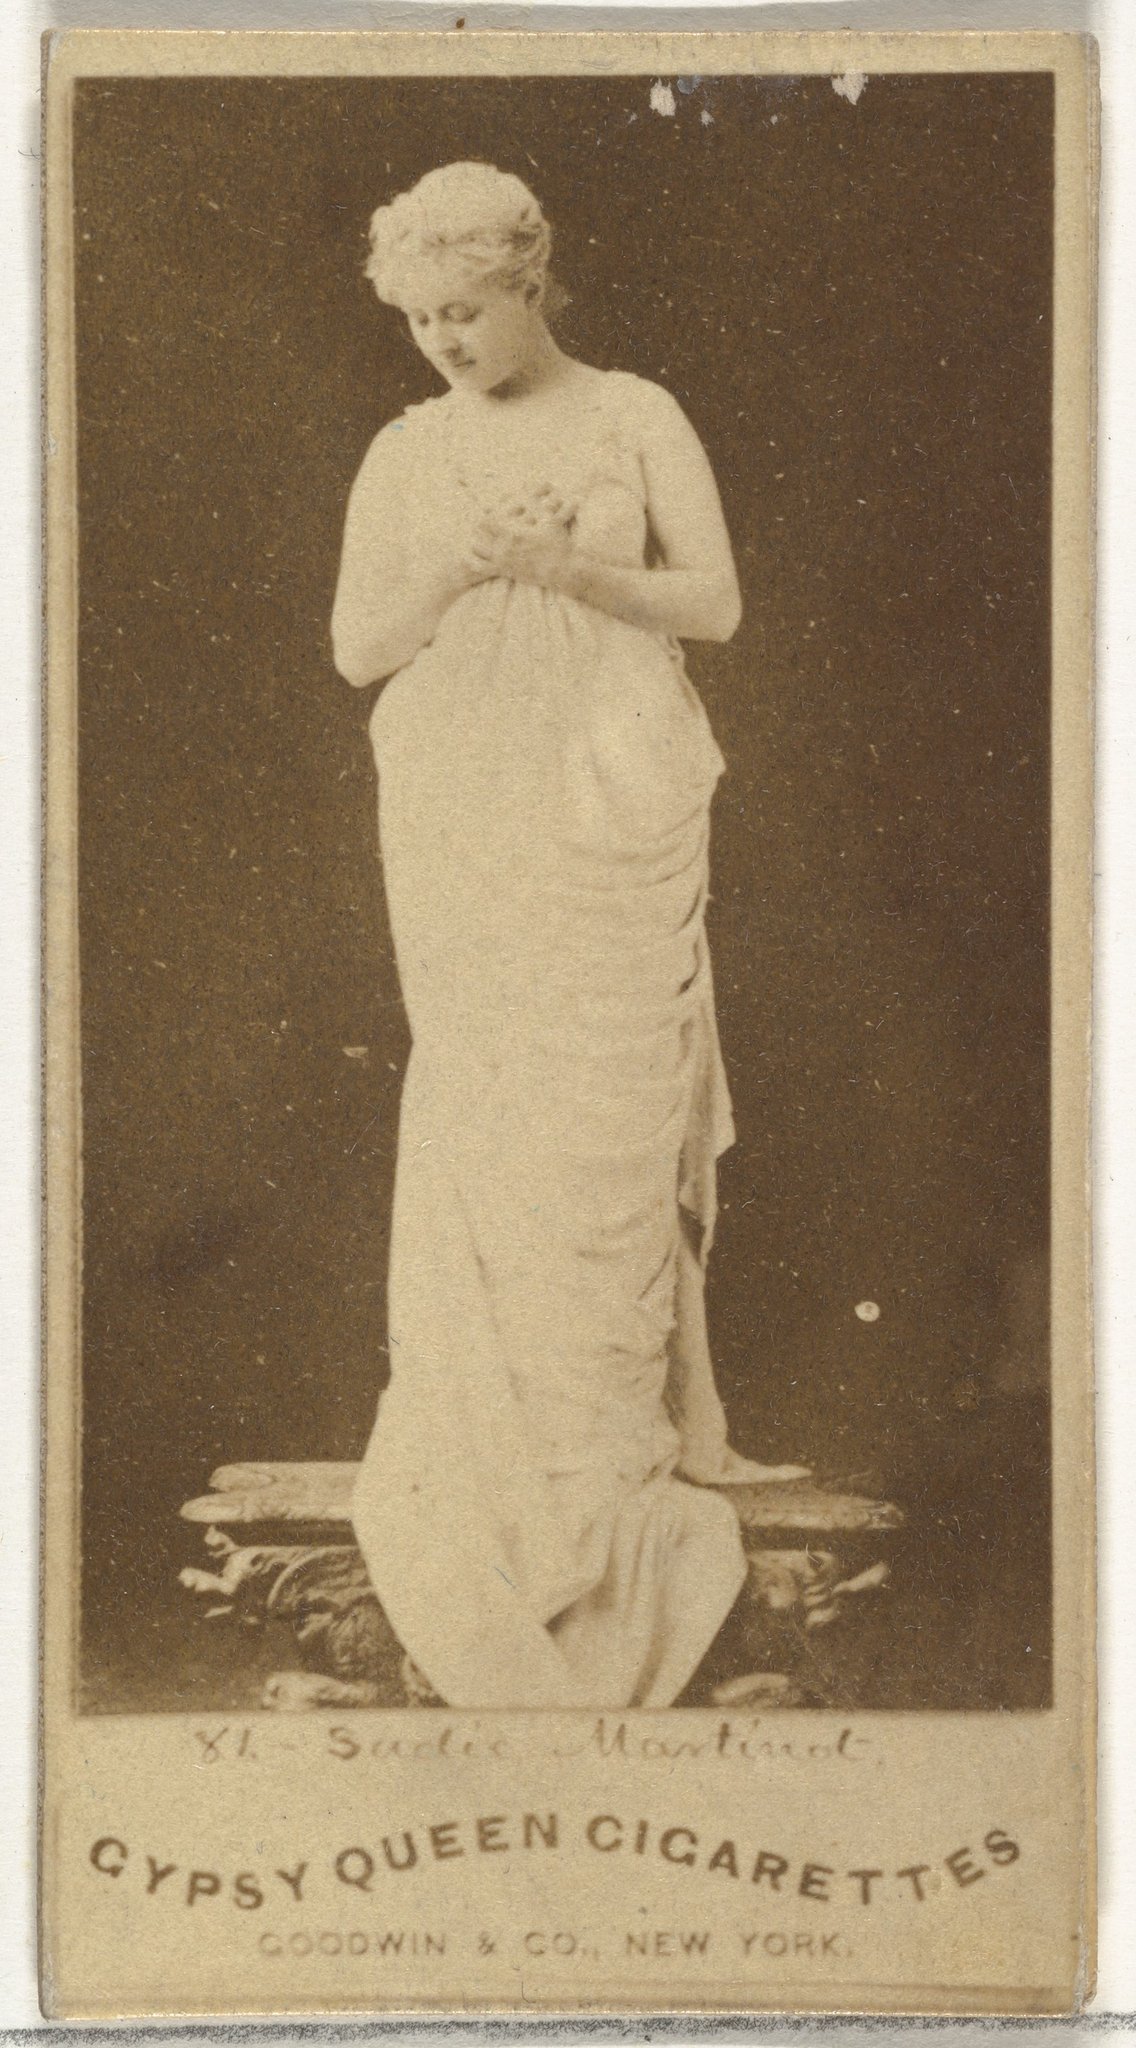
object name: photograph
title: Sadie Martinot, from the Actors and Actresses series (N171) for Gypsy Queen Cigarettes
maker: goodwin & company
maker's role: publisher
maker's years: 1850-1950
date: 1886-1890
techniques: albumen silver print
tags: portraits,women,actresses